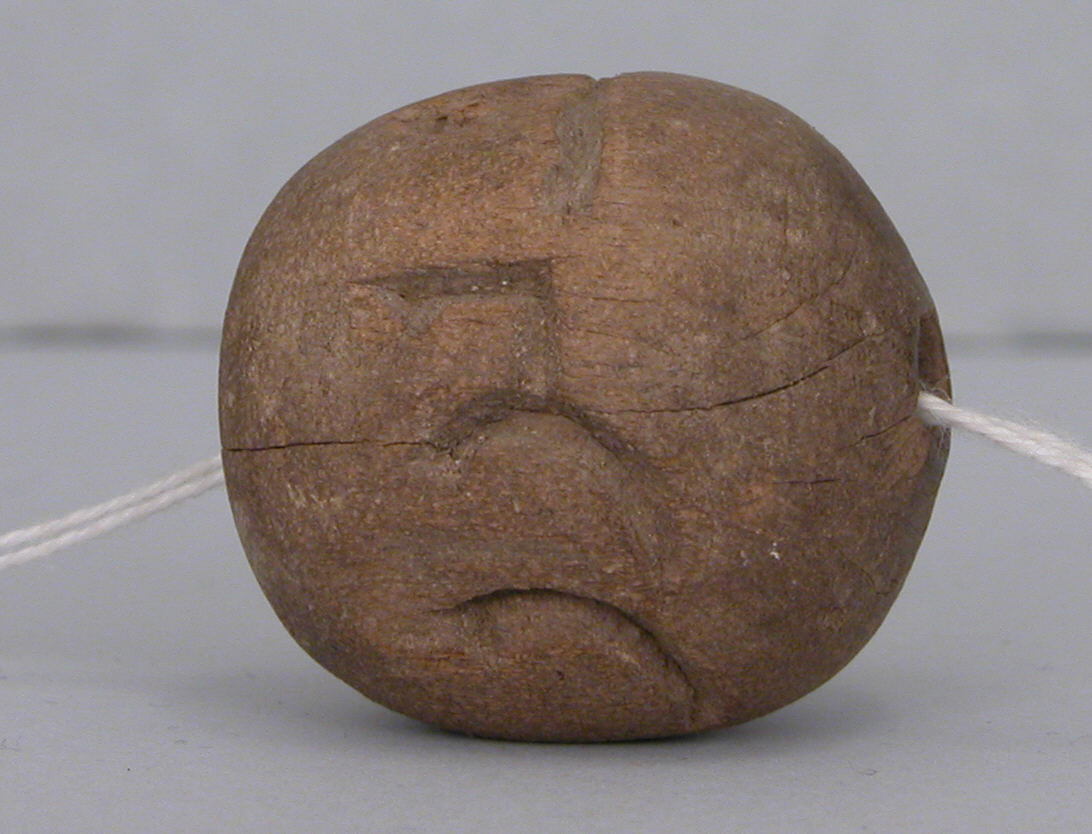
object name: bead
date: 901-1000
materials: wood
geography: egypt